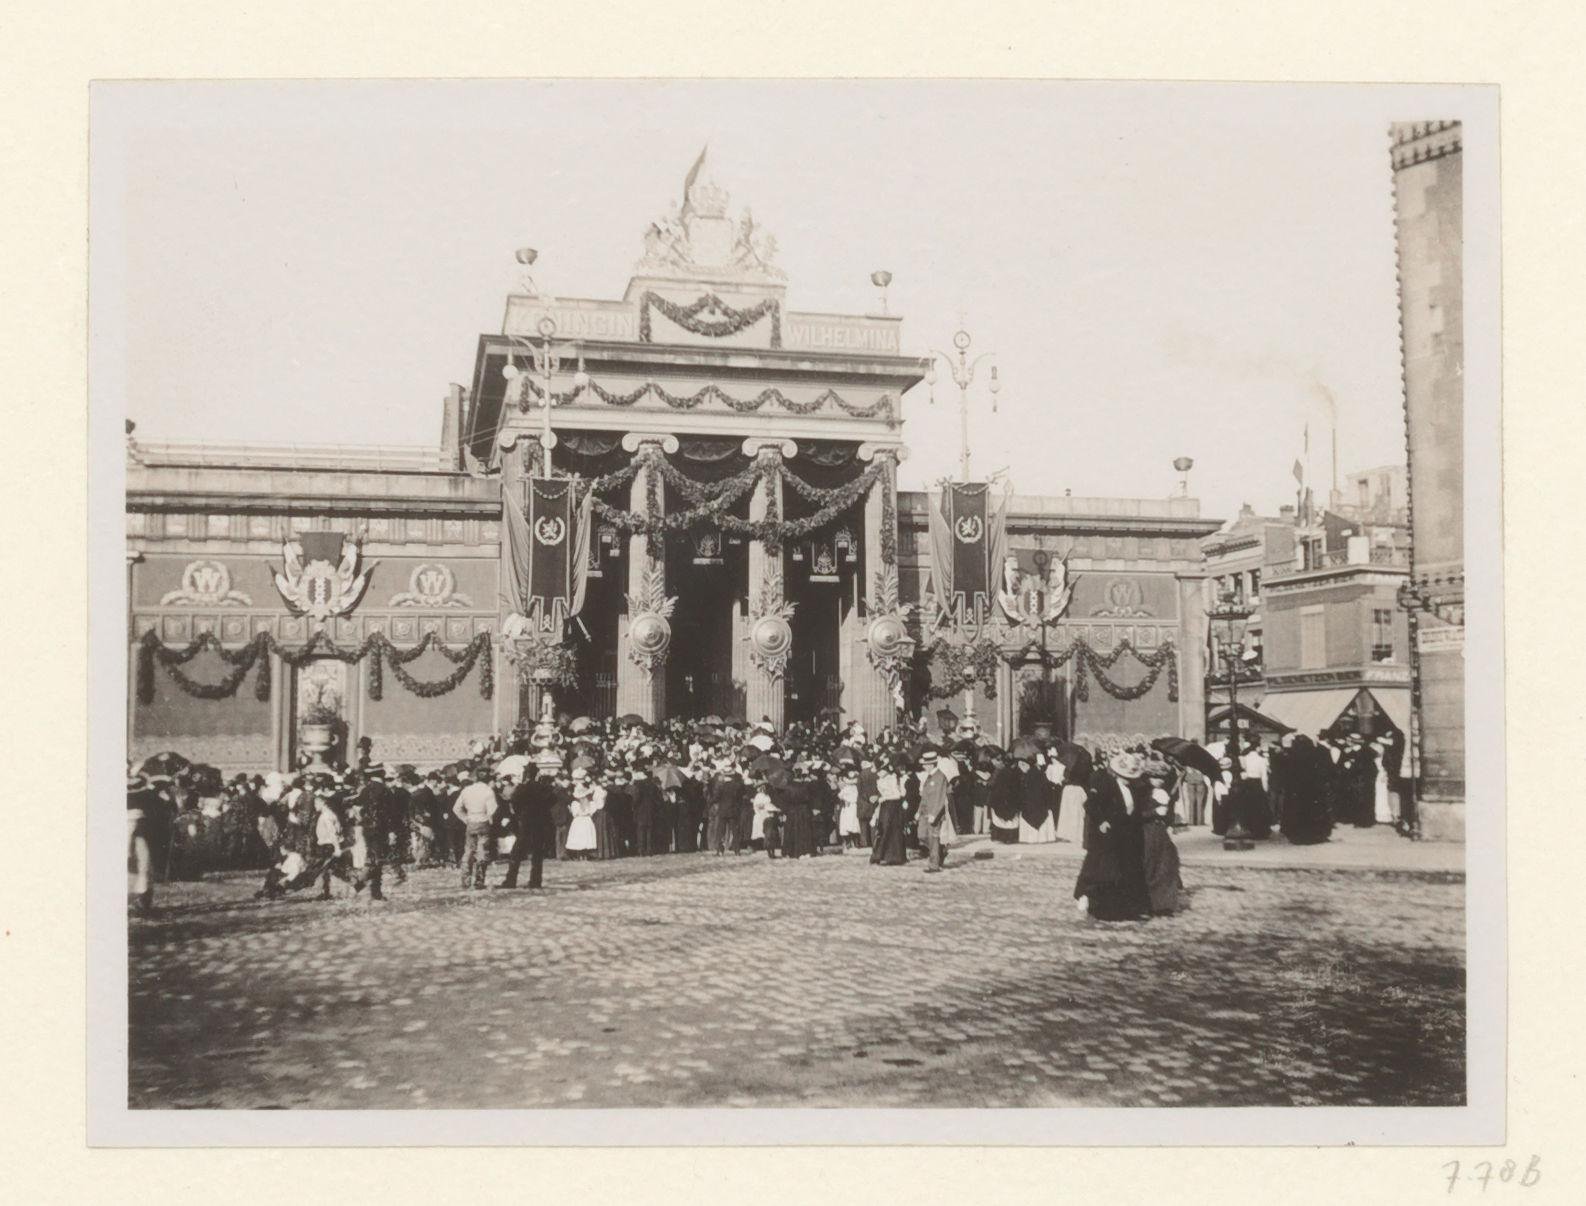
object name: photograph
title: Gezicht op de Beurs van Zocher tijdens de Kroningsfeesten in 1898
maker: Anonymous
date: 1898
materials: paper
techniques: gelatin silver print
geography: amsterdam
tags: square, place, circus, etc., city-view in general; 'veduta', public festivities, market-hall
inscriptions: inscription: ‘Beursdam. / Kroningsfeesten 1898.’, collector's mark: ‘7’ Lugt 1641b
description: Onderwerpsrubriek binnen de Atlas Amsterdam: Dam (na 1835).